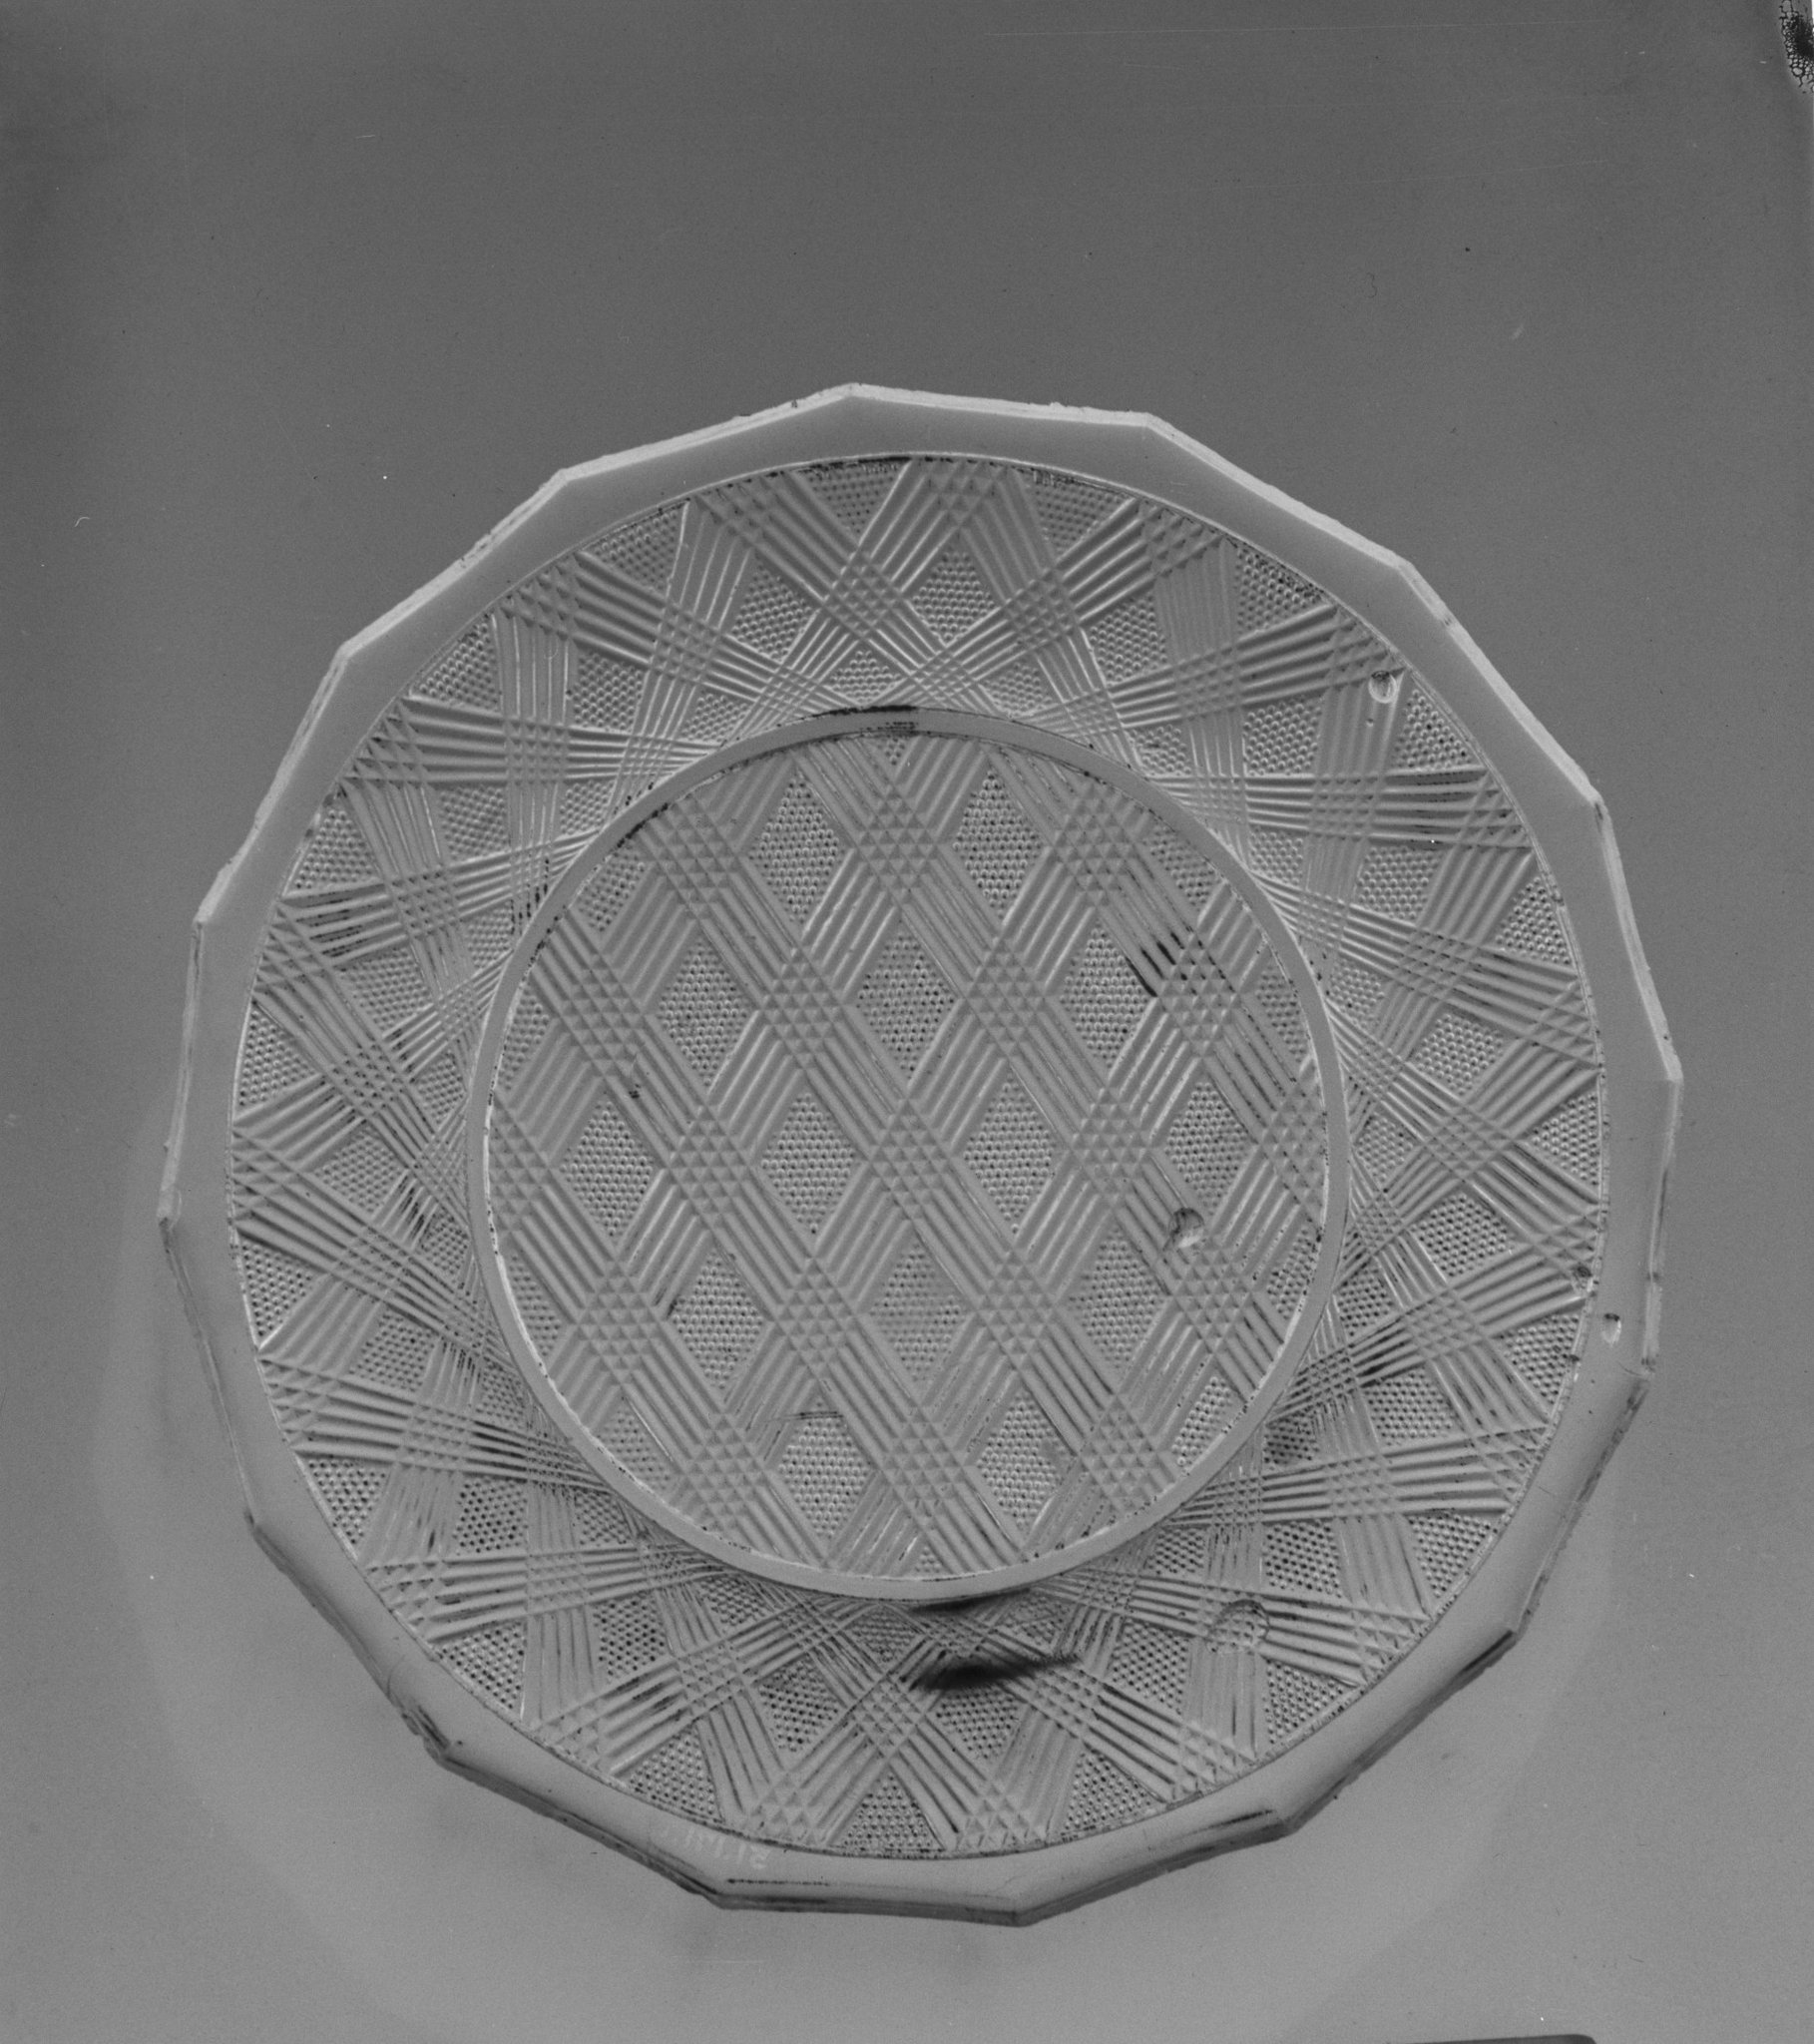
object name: plate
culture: american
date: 1825-1830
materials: glass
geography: united states